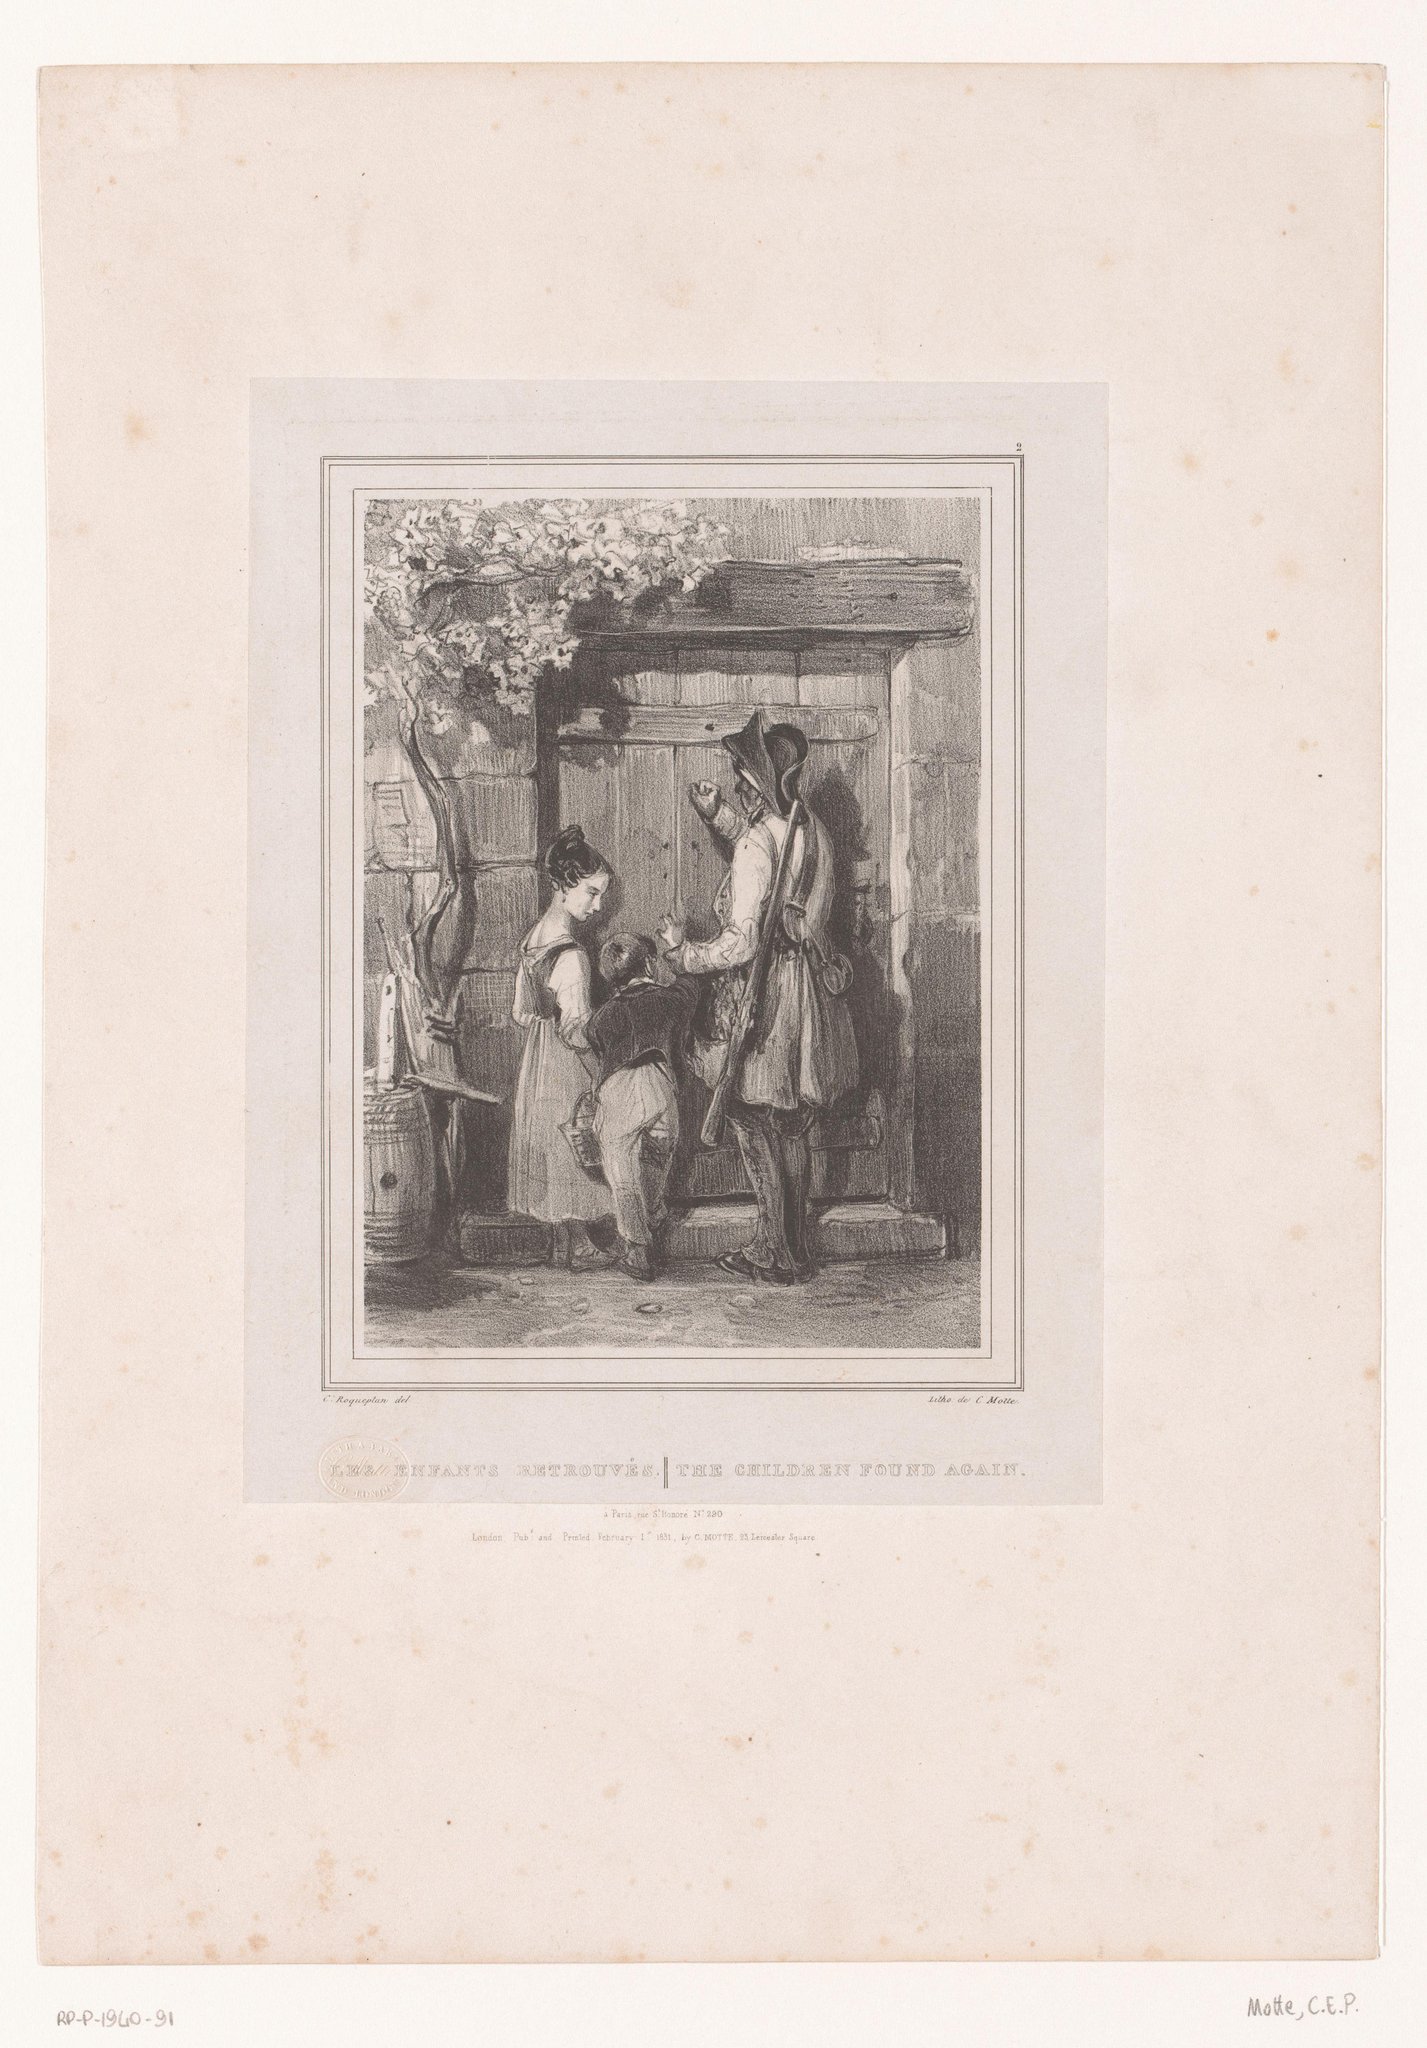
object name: print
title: Twaalf afbeeldingen over het dagelijks leven van kinderen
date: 1831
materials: paper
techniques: lithograph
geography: london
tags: hunter, child, return of runaway child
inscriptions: collector's mark: Lugt 2166, check stamp: Lugt 1828b, collector's mark: Lugt 2760